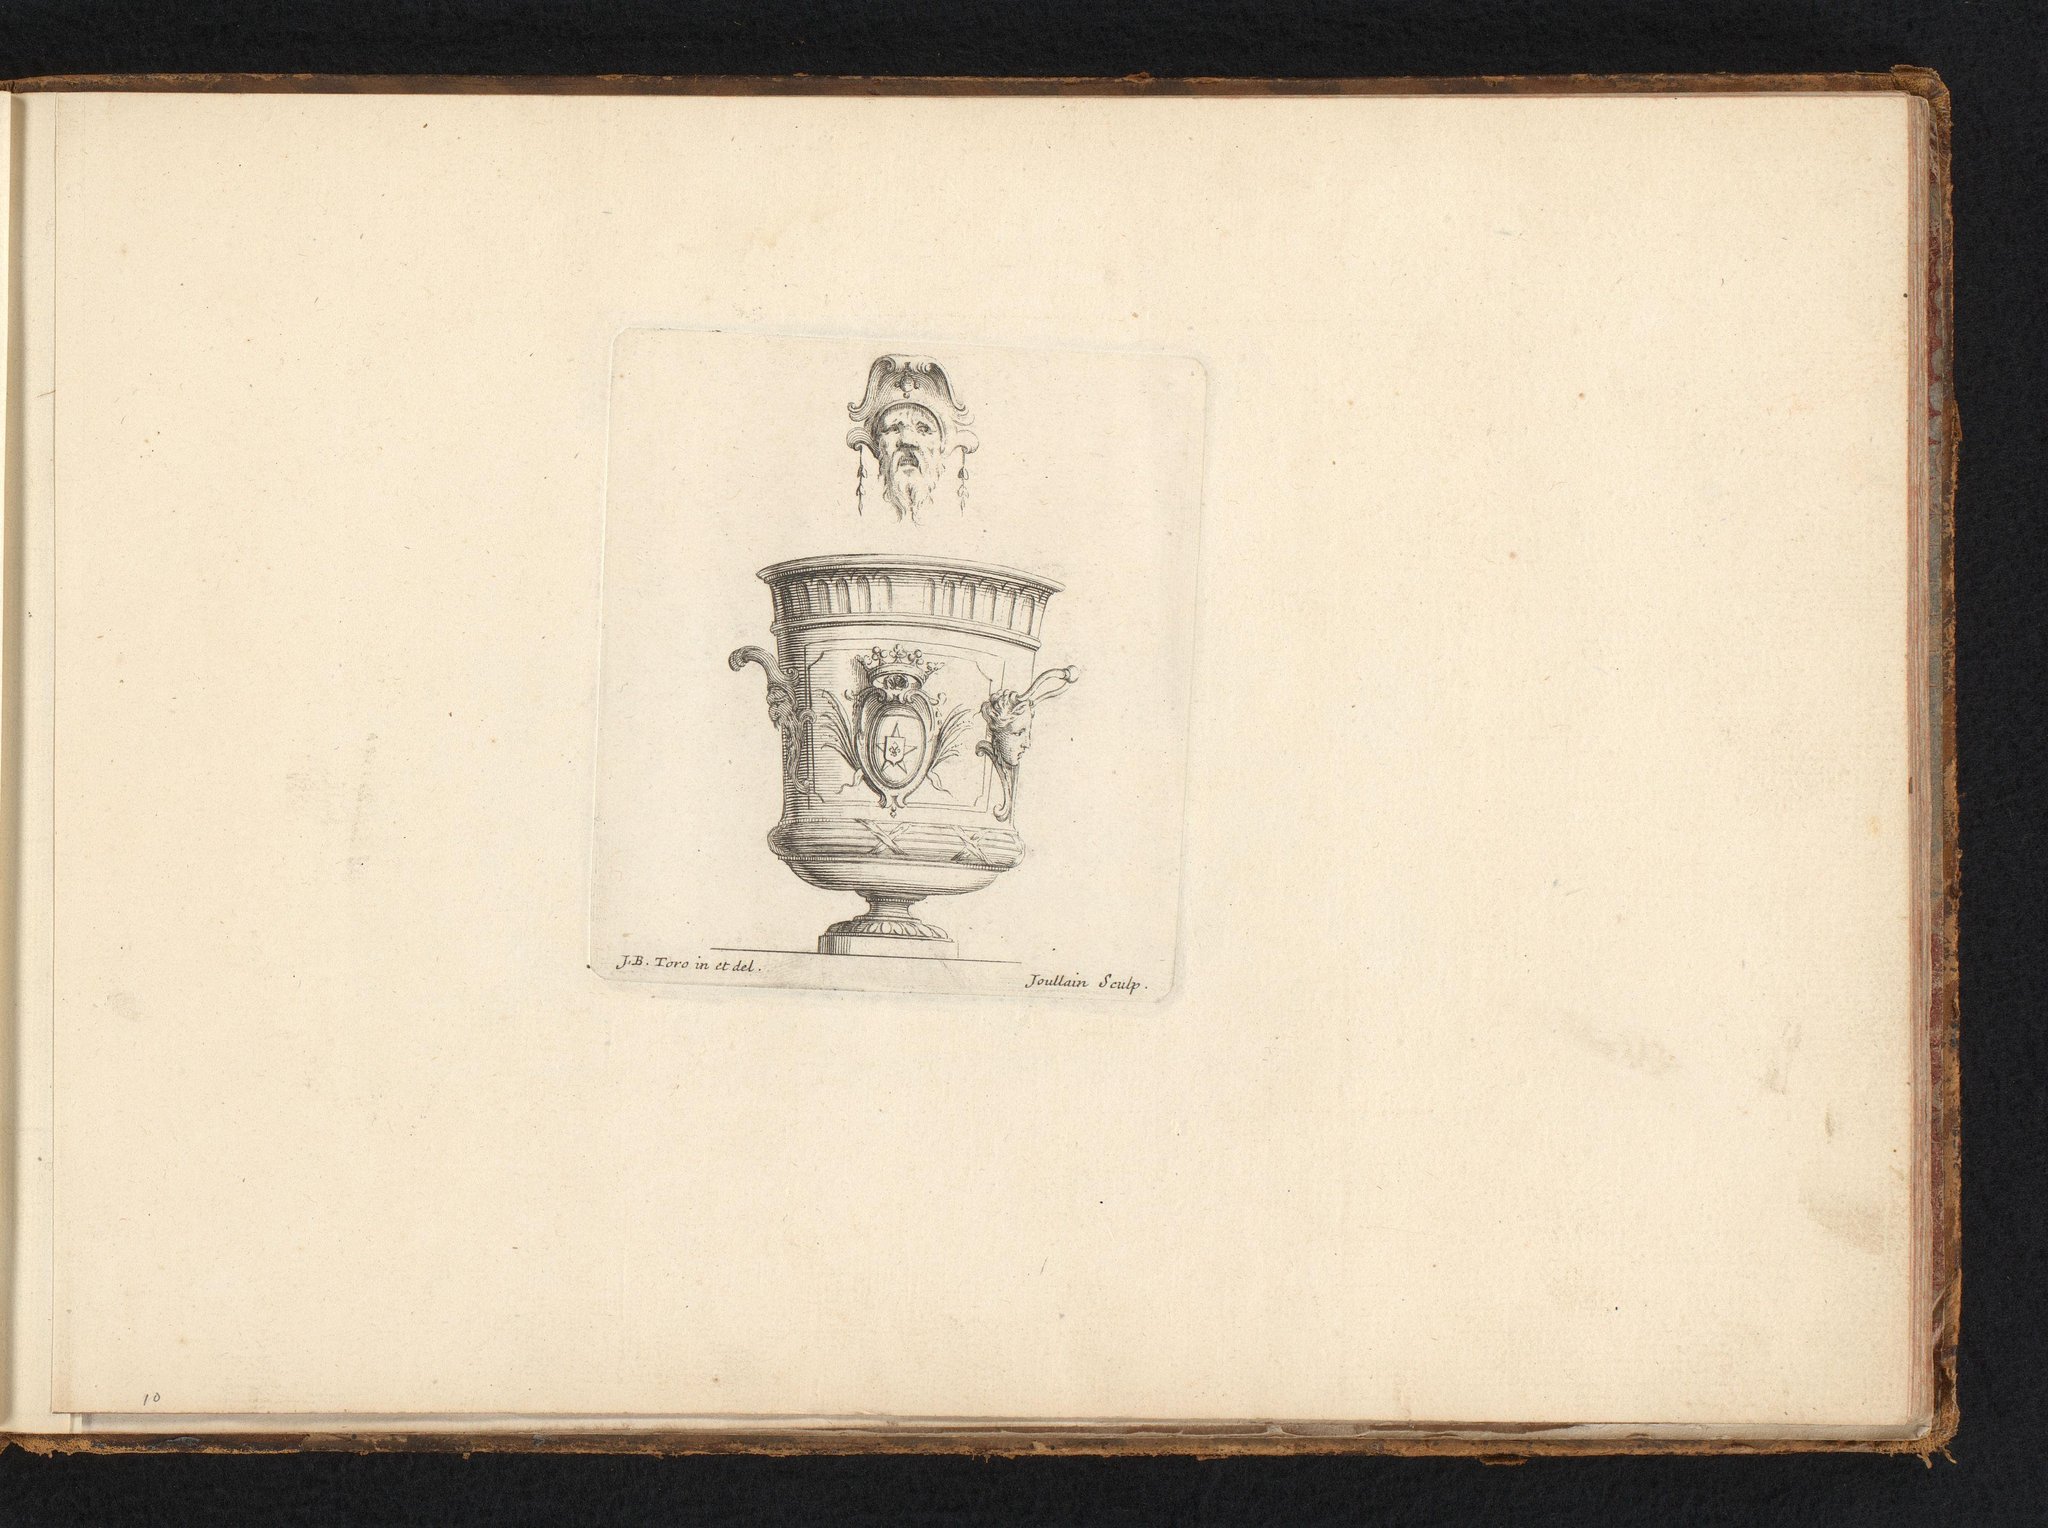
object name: print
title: Nouveau Livre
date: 1682-1731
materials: paper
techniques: etching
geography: paris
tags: mask, mascaron ~ ornament, garden vase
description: Prent maakt deel uit van een serie van zes prenten.